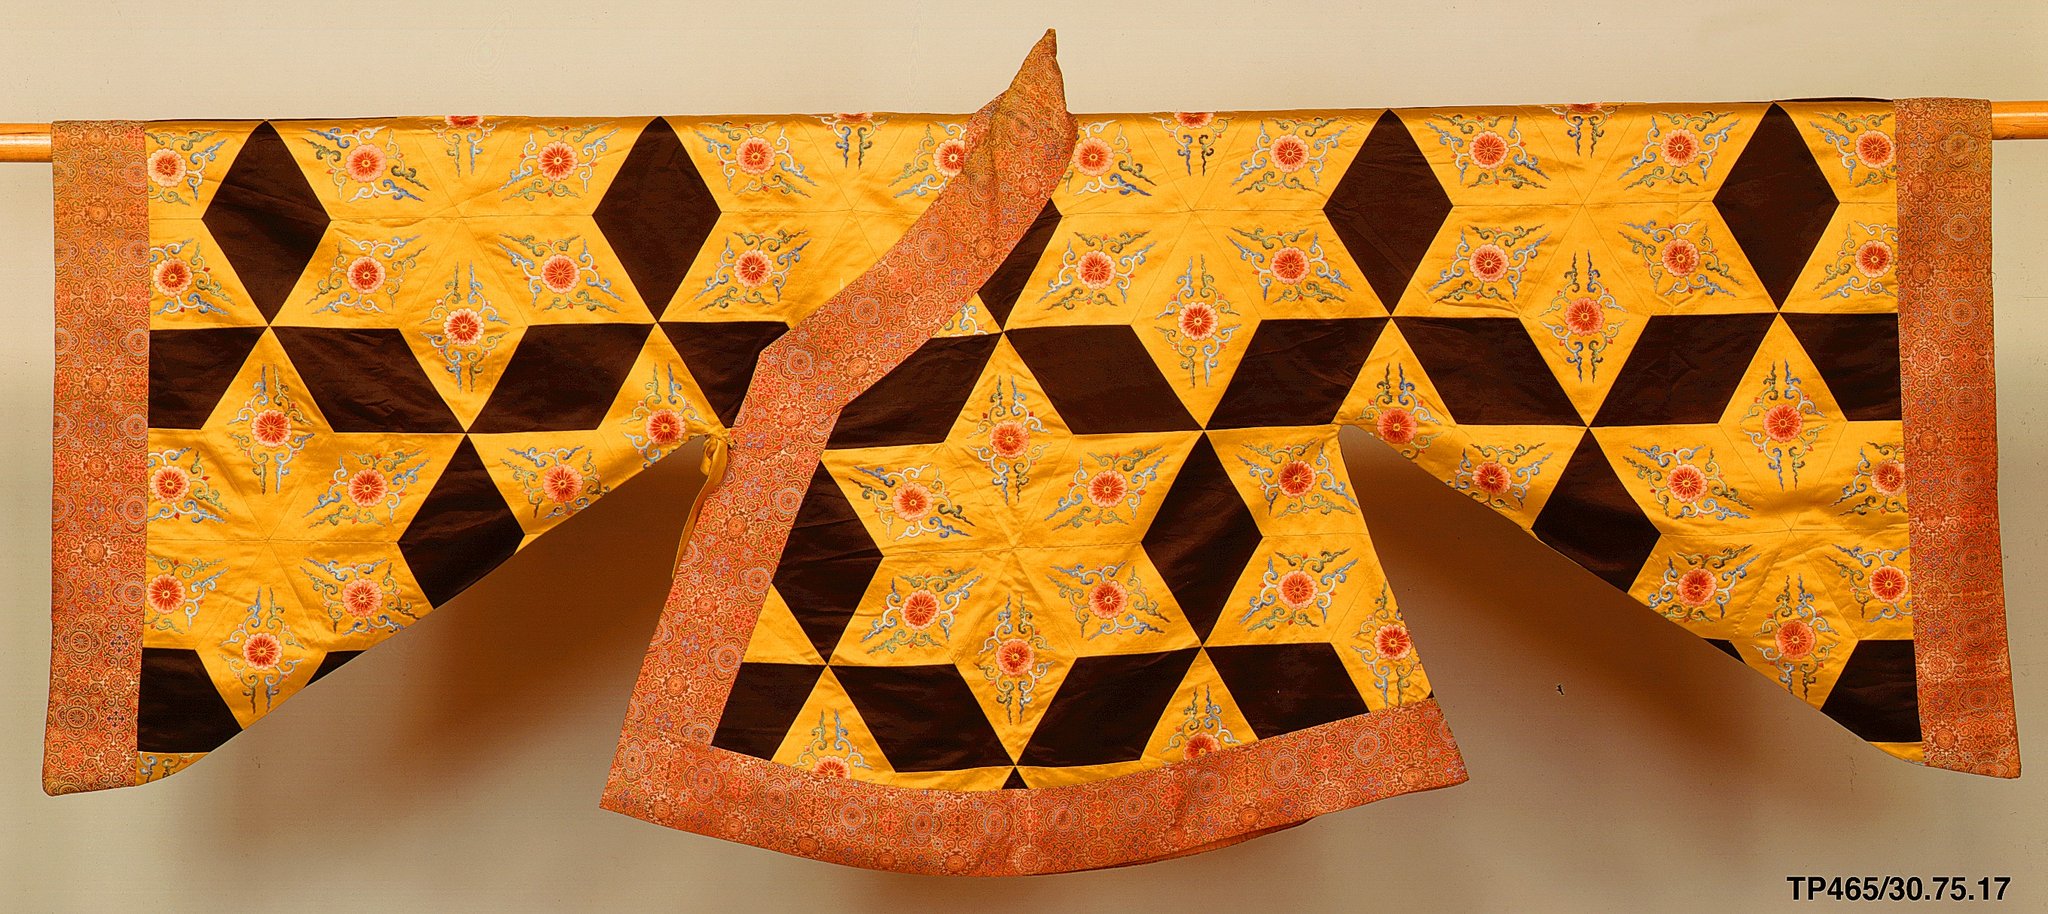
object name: coat, imperial theatrical, for court lady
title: Imperial Theatrical Coat for Court Lady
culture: chinese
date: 1701-1800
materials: metal thread, silk